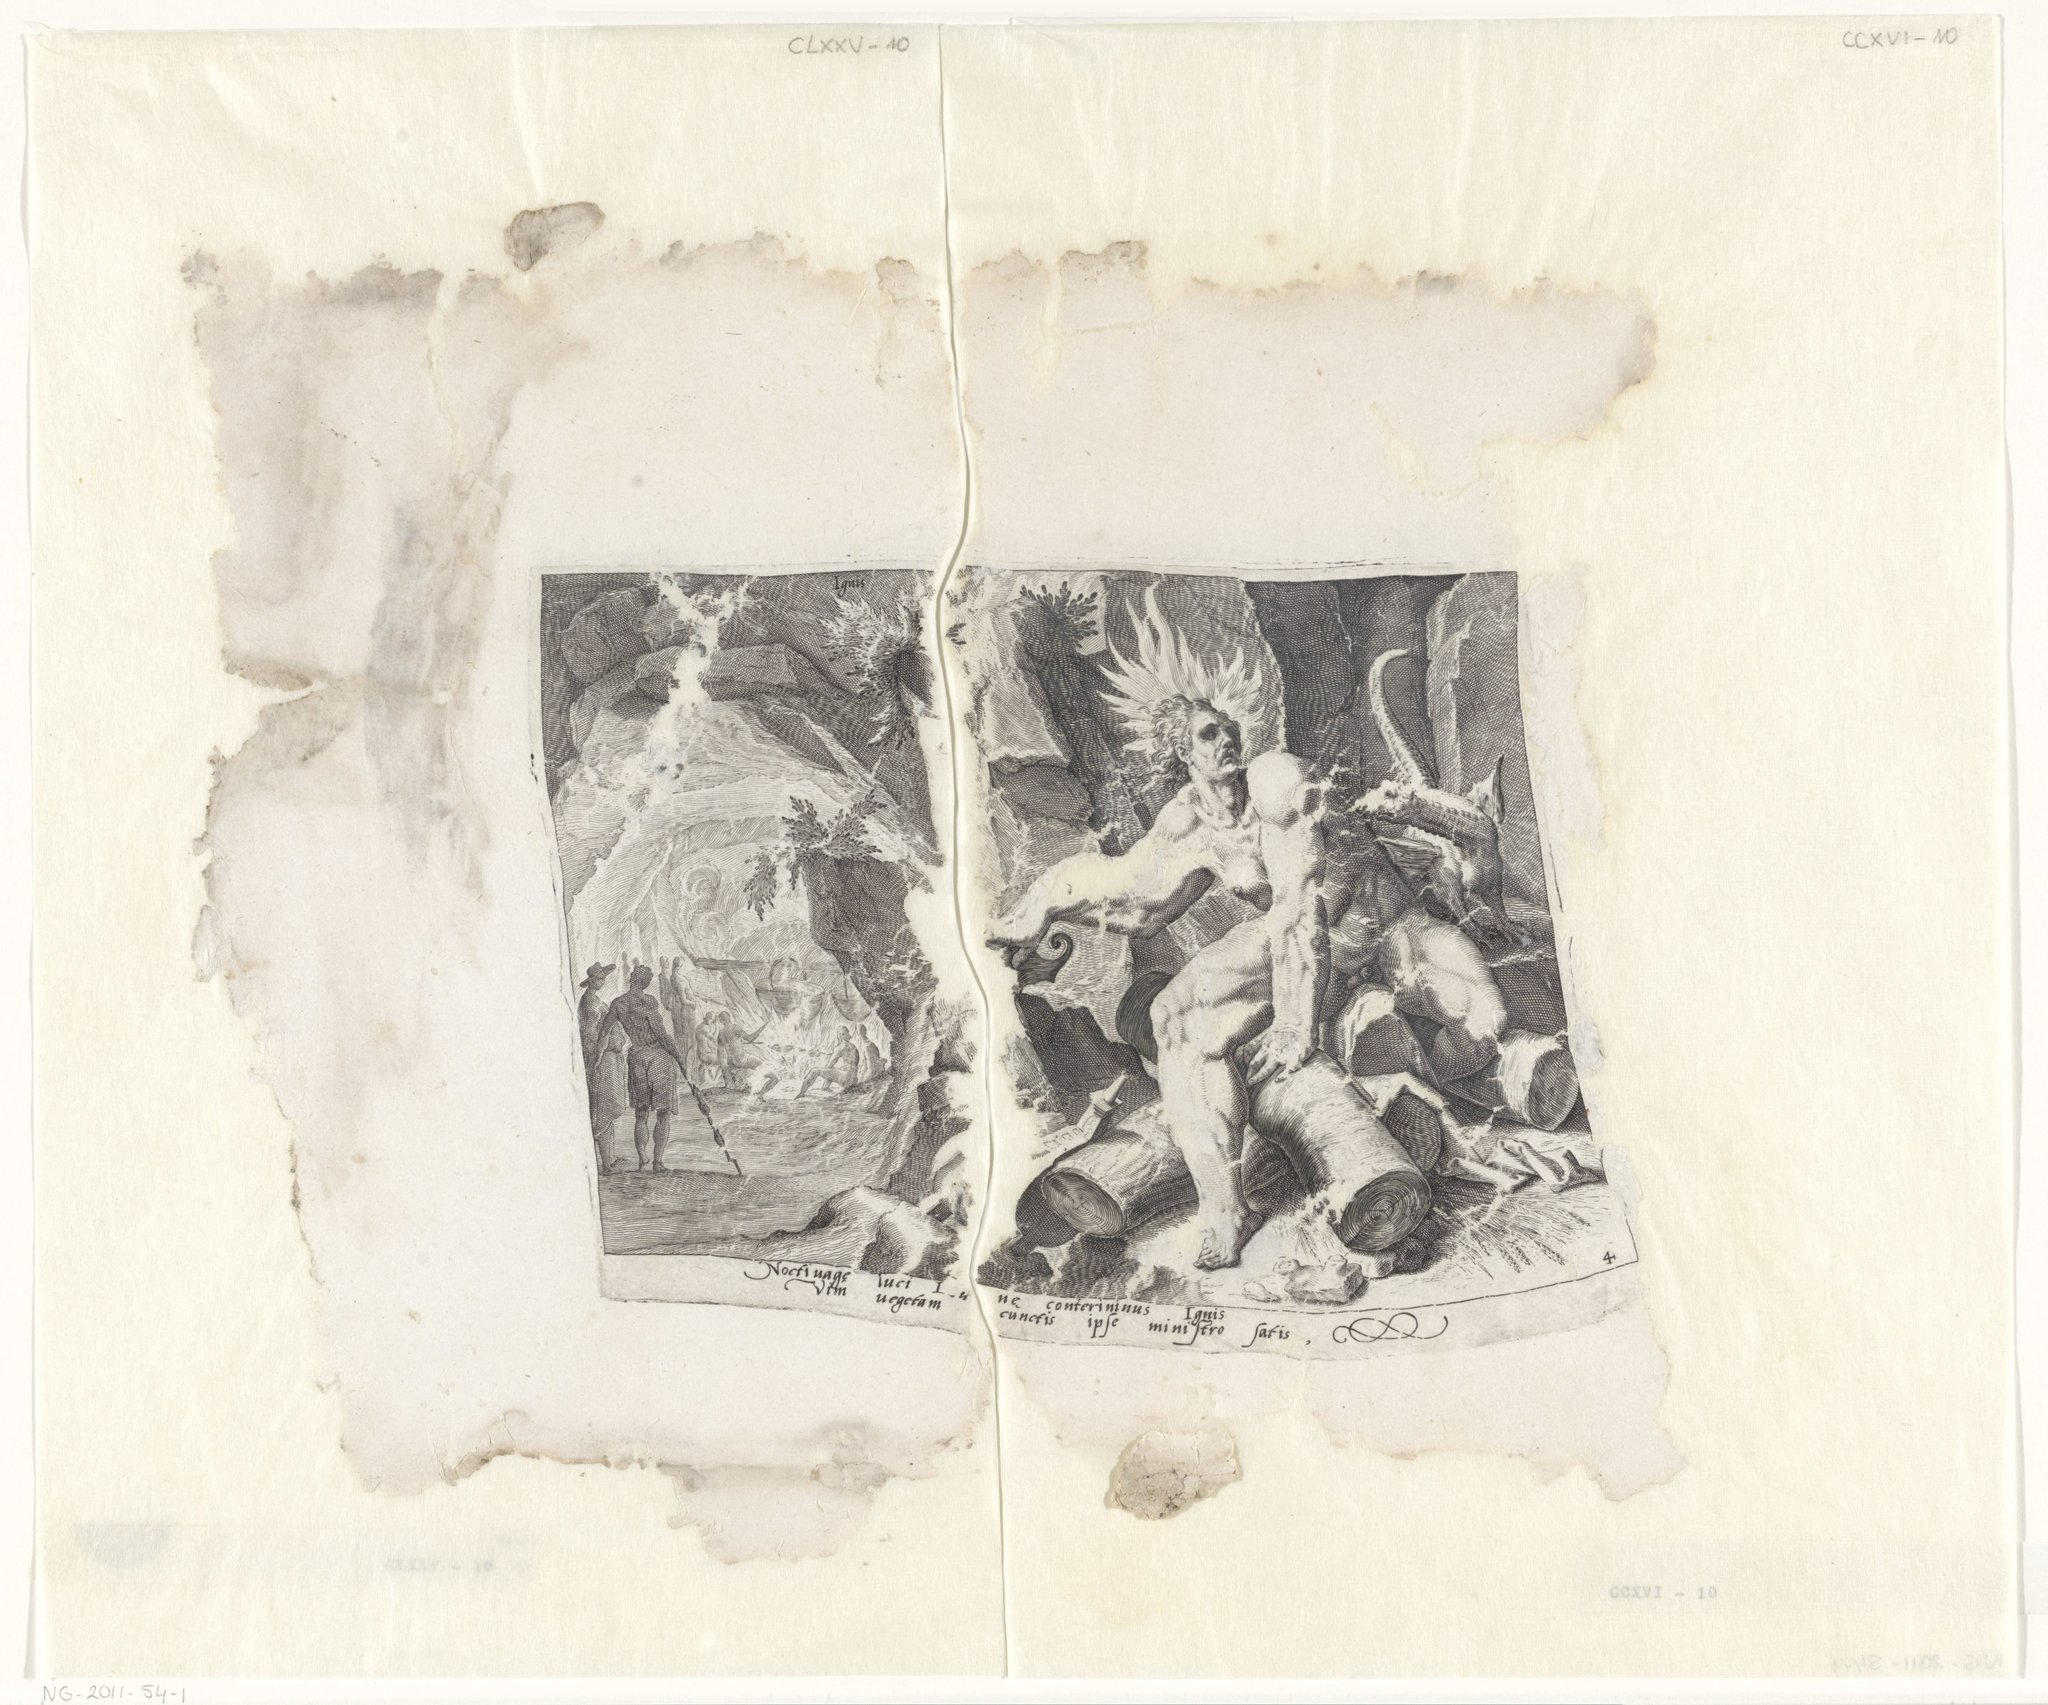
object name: print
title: Ignis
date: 1580-1596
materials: paper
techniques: engraving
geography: amsterdam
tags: fire (one of the four elements)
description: De prenten in de Nova Zembla collectie zijn tijdens een expeditie van Willem Barendsz en Jacob van Heemskerk in 1596-1597 noodgedwongen in het winterkamp, het ‘Behouden Huis’, op het eiland achtergelaten. De prenten waren in één of meerdere stapels als handelswaar meegenomen vanuit Amsterdam. Bijna drie eeuwen later, in 1871, keerde de Noor Elling Carlsen terug naar Nova Zembla en vond daar de restanten van het ‘Behouden Huis, inclusief een groot deel van de inventaris. Een deel van de prenten, in de vorm van aaneengekoekte kluiten, werd toen ook teruggevonden. De papierkluiten waren soms op meerdere plekken gebroken. Tussen 1975-1979 zijn de prenten van elkaar gescheiden. Dit leverde in totaal ca. 1000 fragmenten van ca. 400 afdrukken van ca. 150 verschillende prenten op. Voor zover mogelijk zijn de fragmenten samengevoegd en zijn de prenten gereconstrueerd.